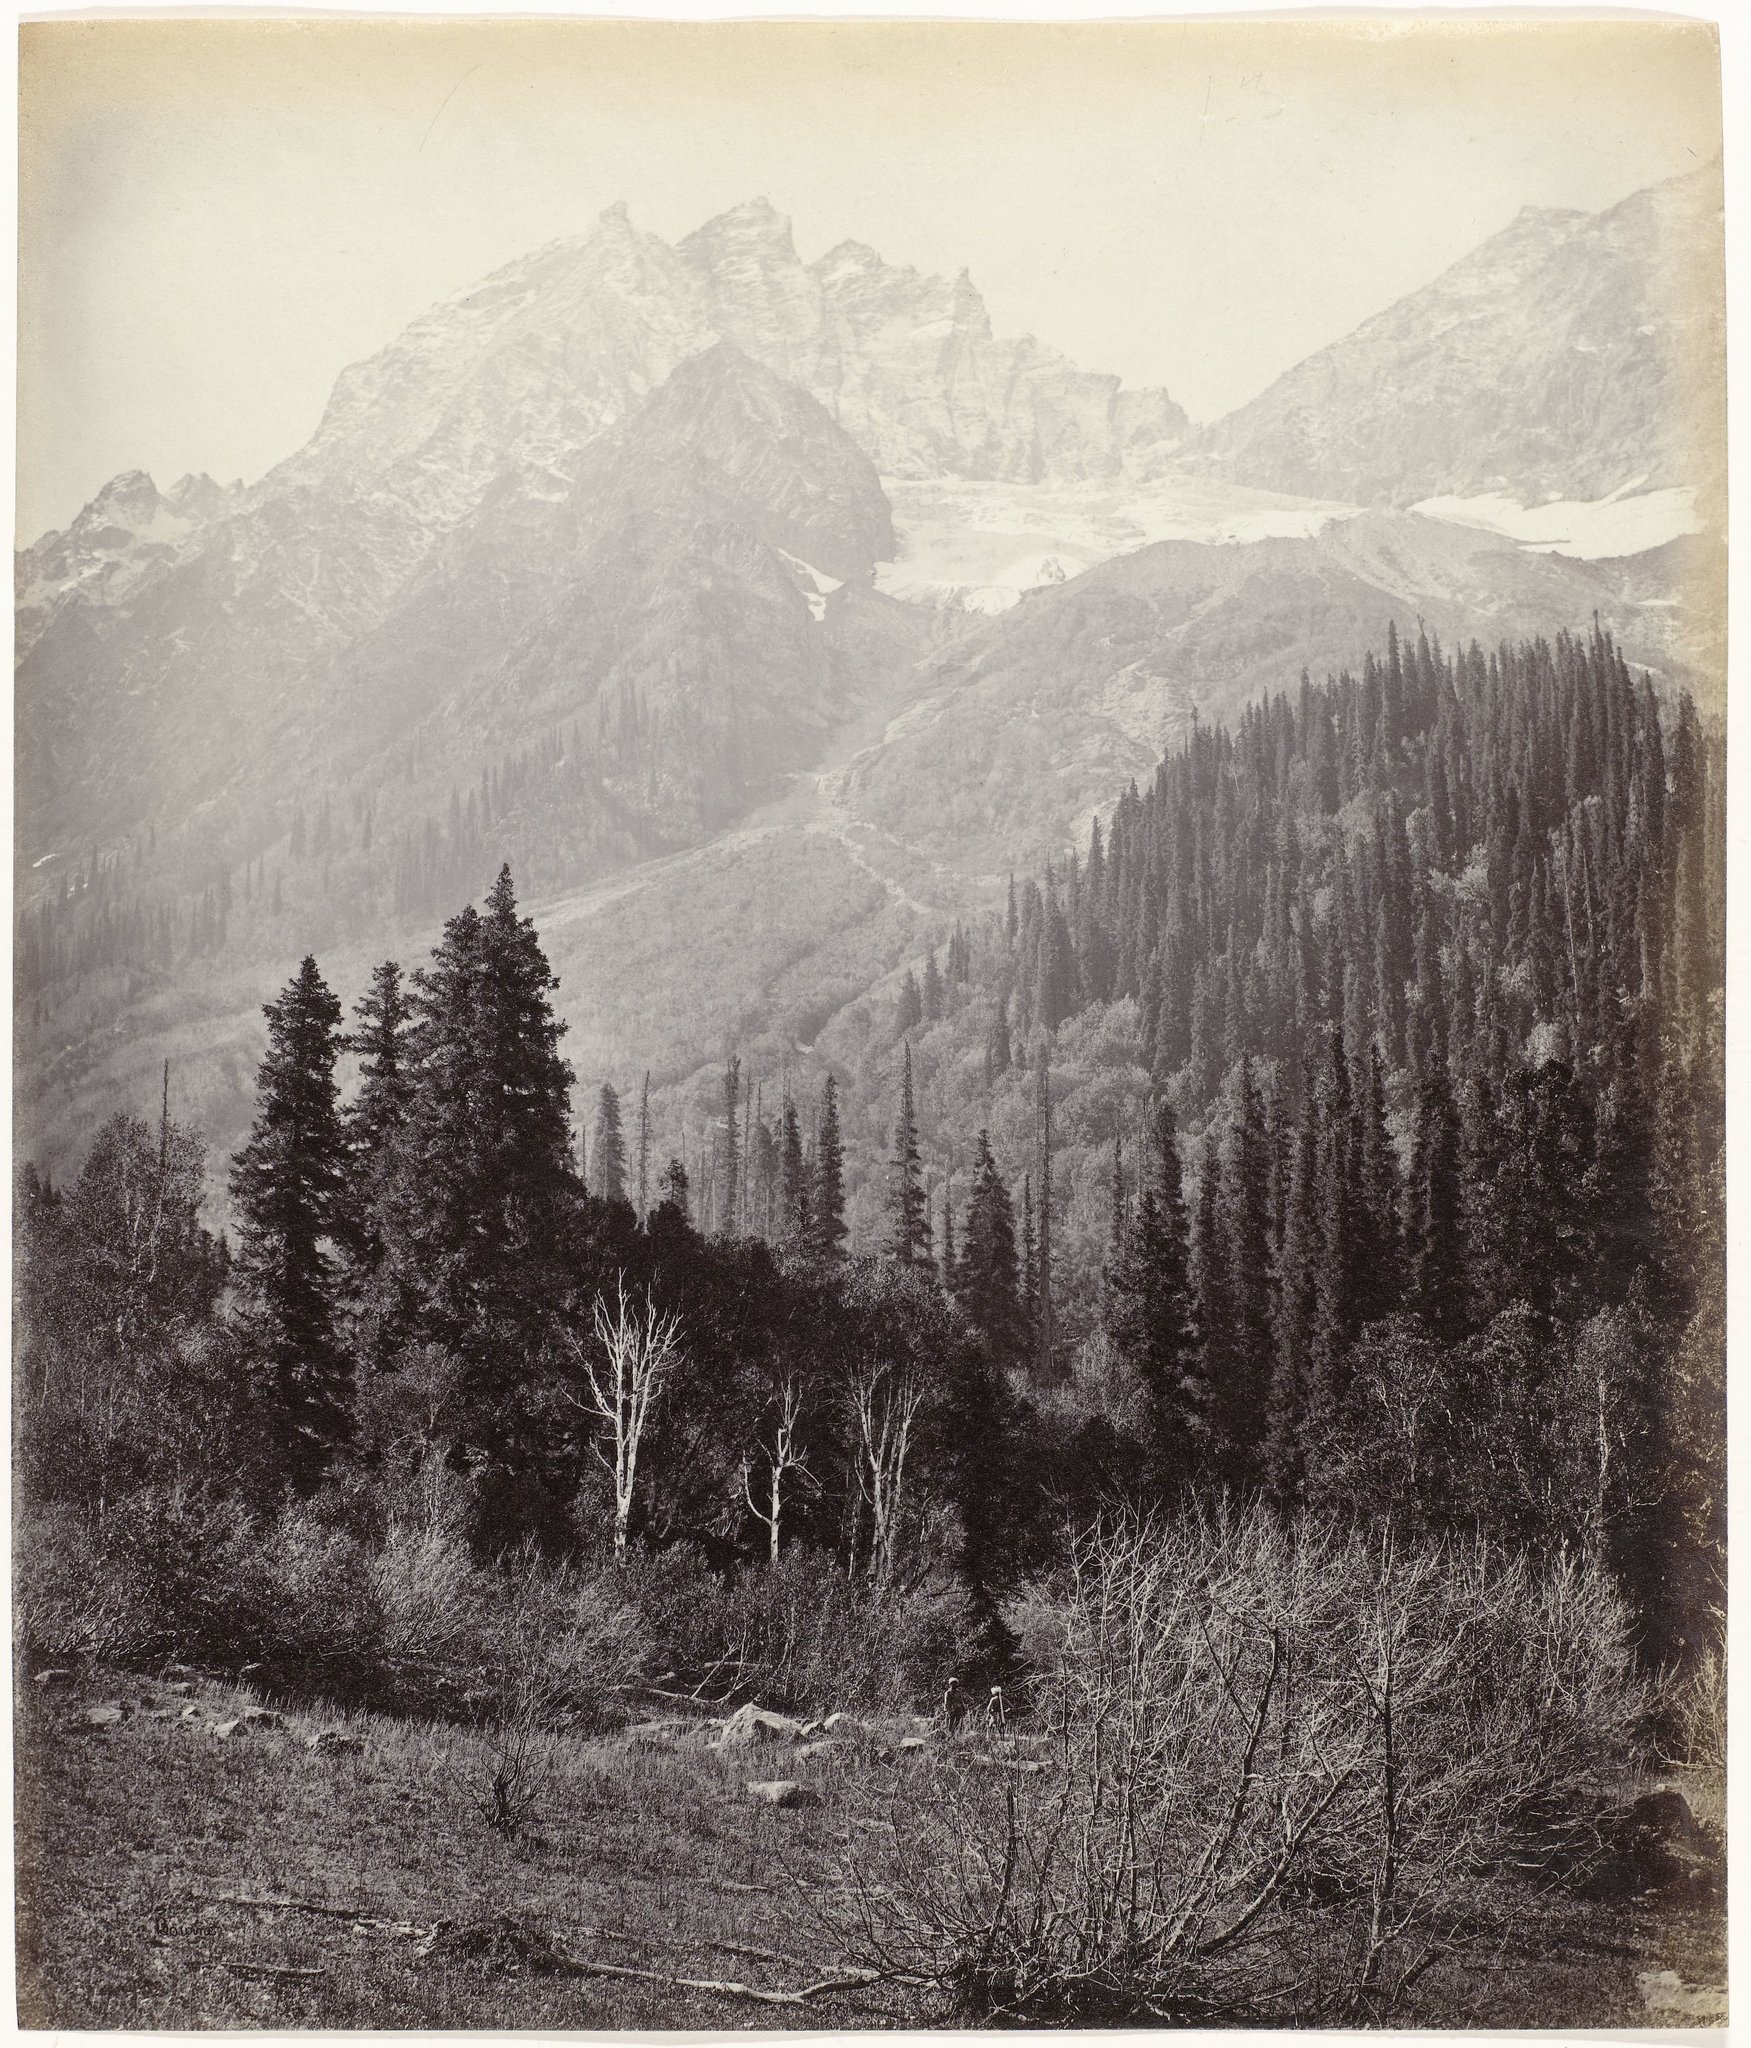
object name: photograph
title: View of the glacier near Sonamarg, Jammu & Kashmir, India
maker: samuel bourne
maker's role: fotograaf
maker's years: 1834-1912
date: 1864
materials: paper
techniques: albumen print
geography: jammu and kashmir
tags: glacier, mountains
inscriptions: number: ‘984’, inscription: ‘Glaciers near Sonamurgh/ Cashmere’